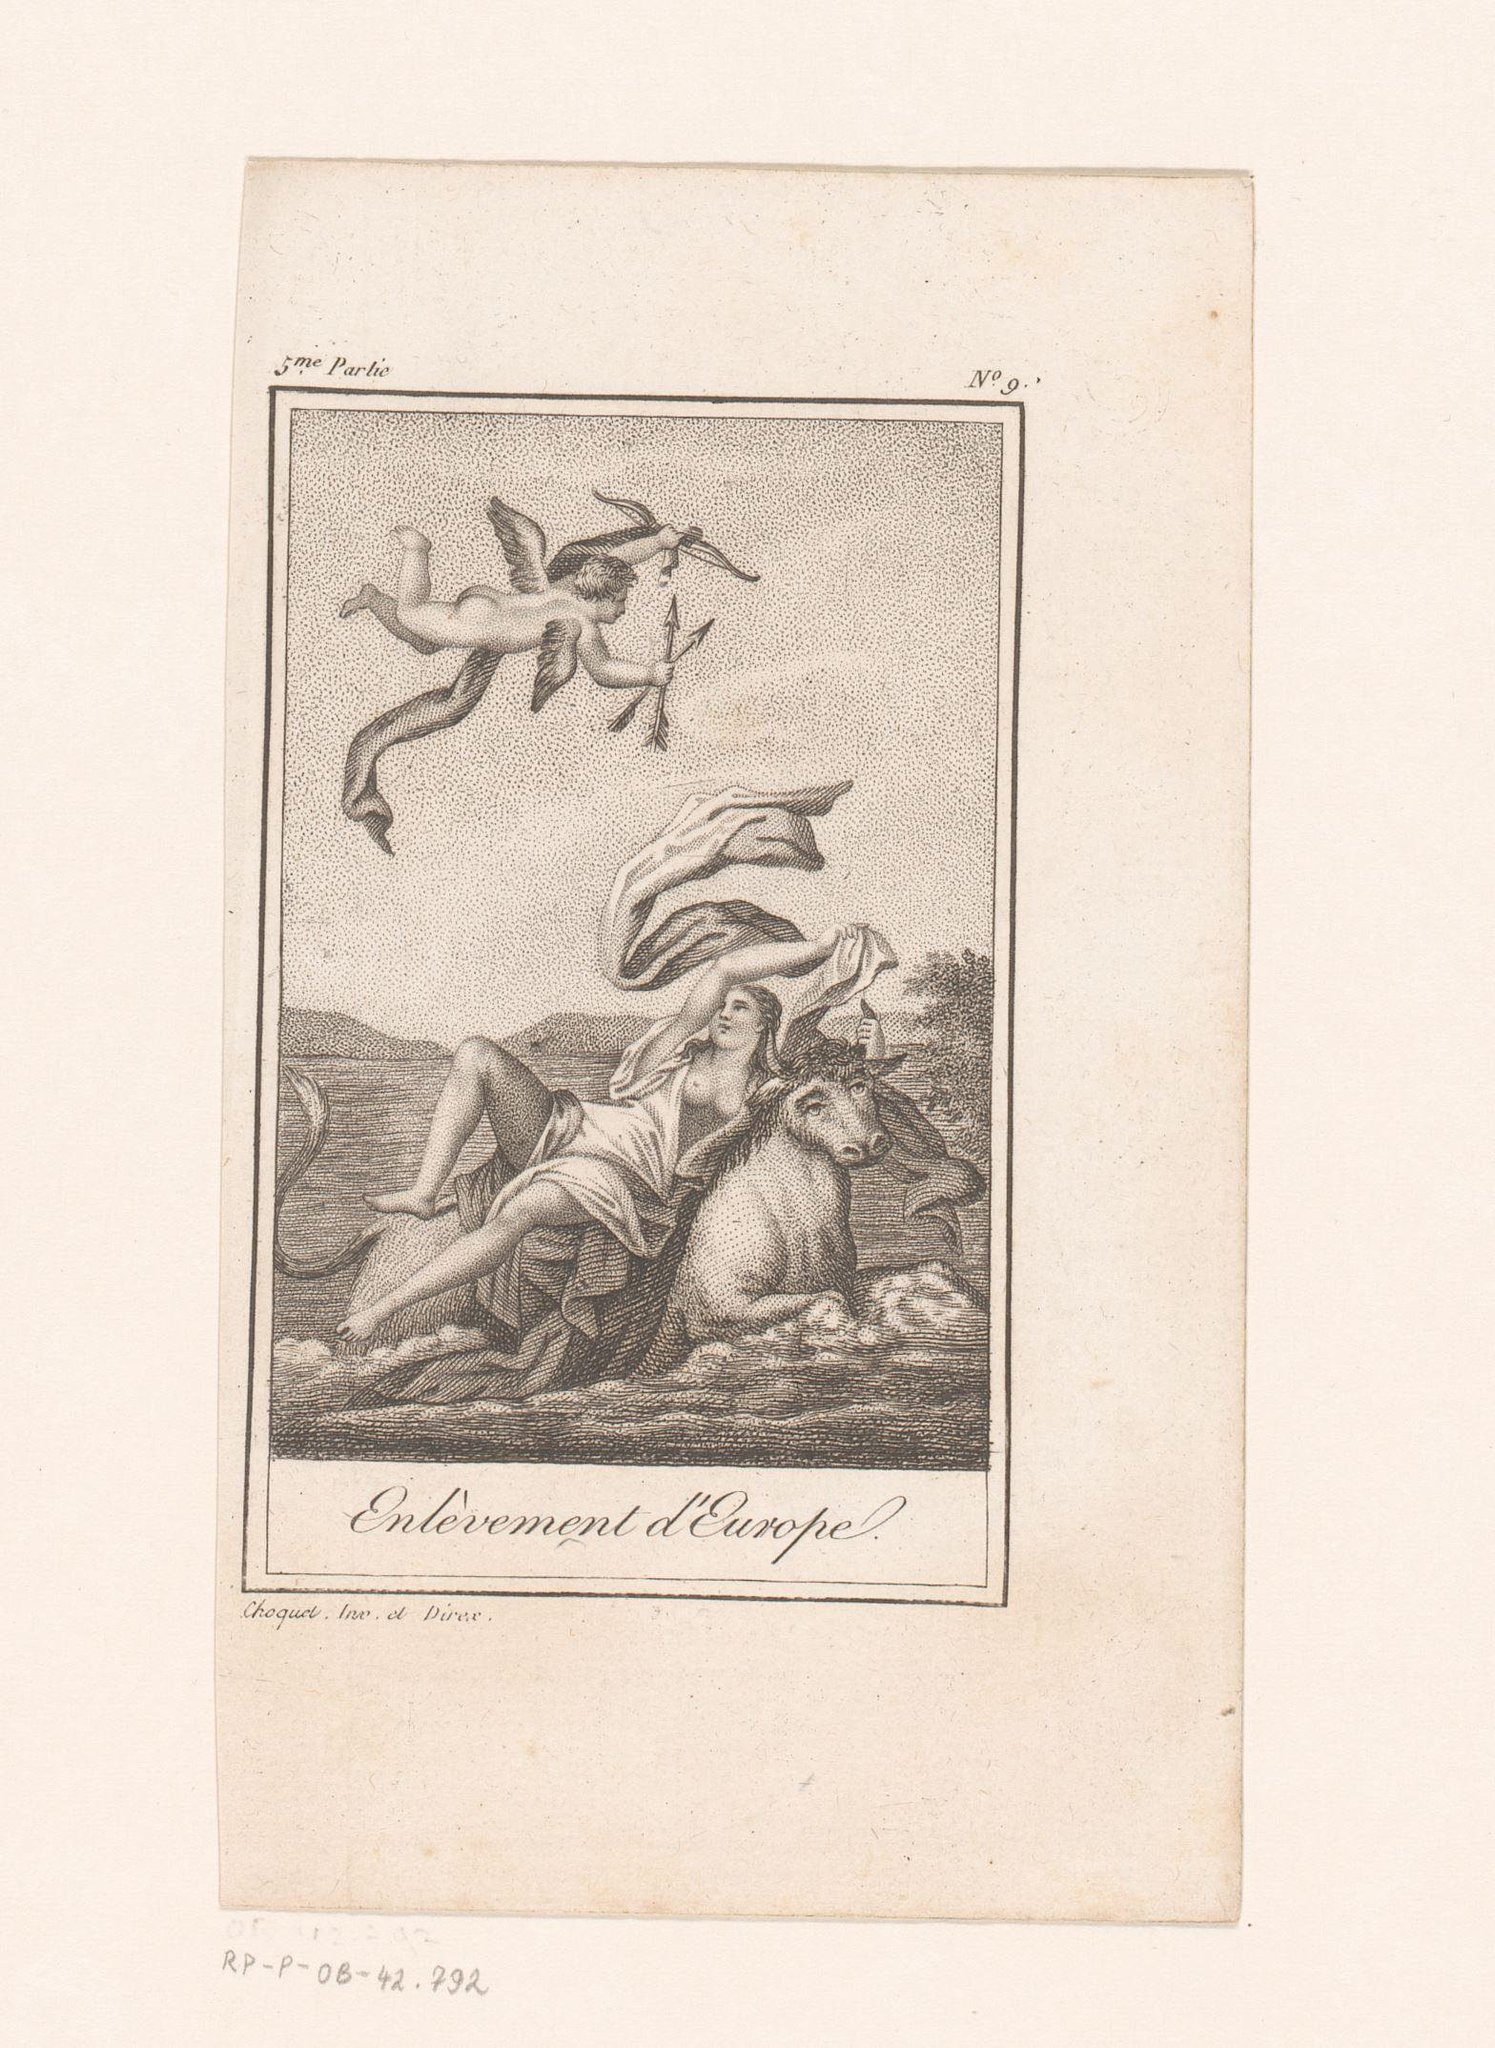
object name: print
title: Roof van Europa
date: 1784-1824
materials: paper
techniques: engraving, etching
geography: france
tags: jupiter, usually in the shape of a white bull, abducts europa and carries her across the water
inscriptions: collector's mark: Lugt 2228